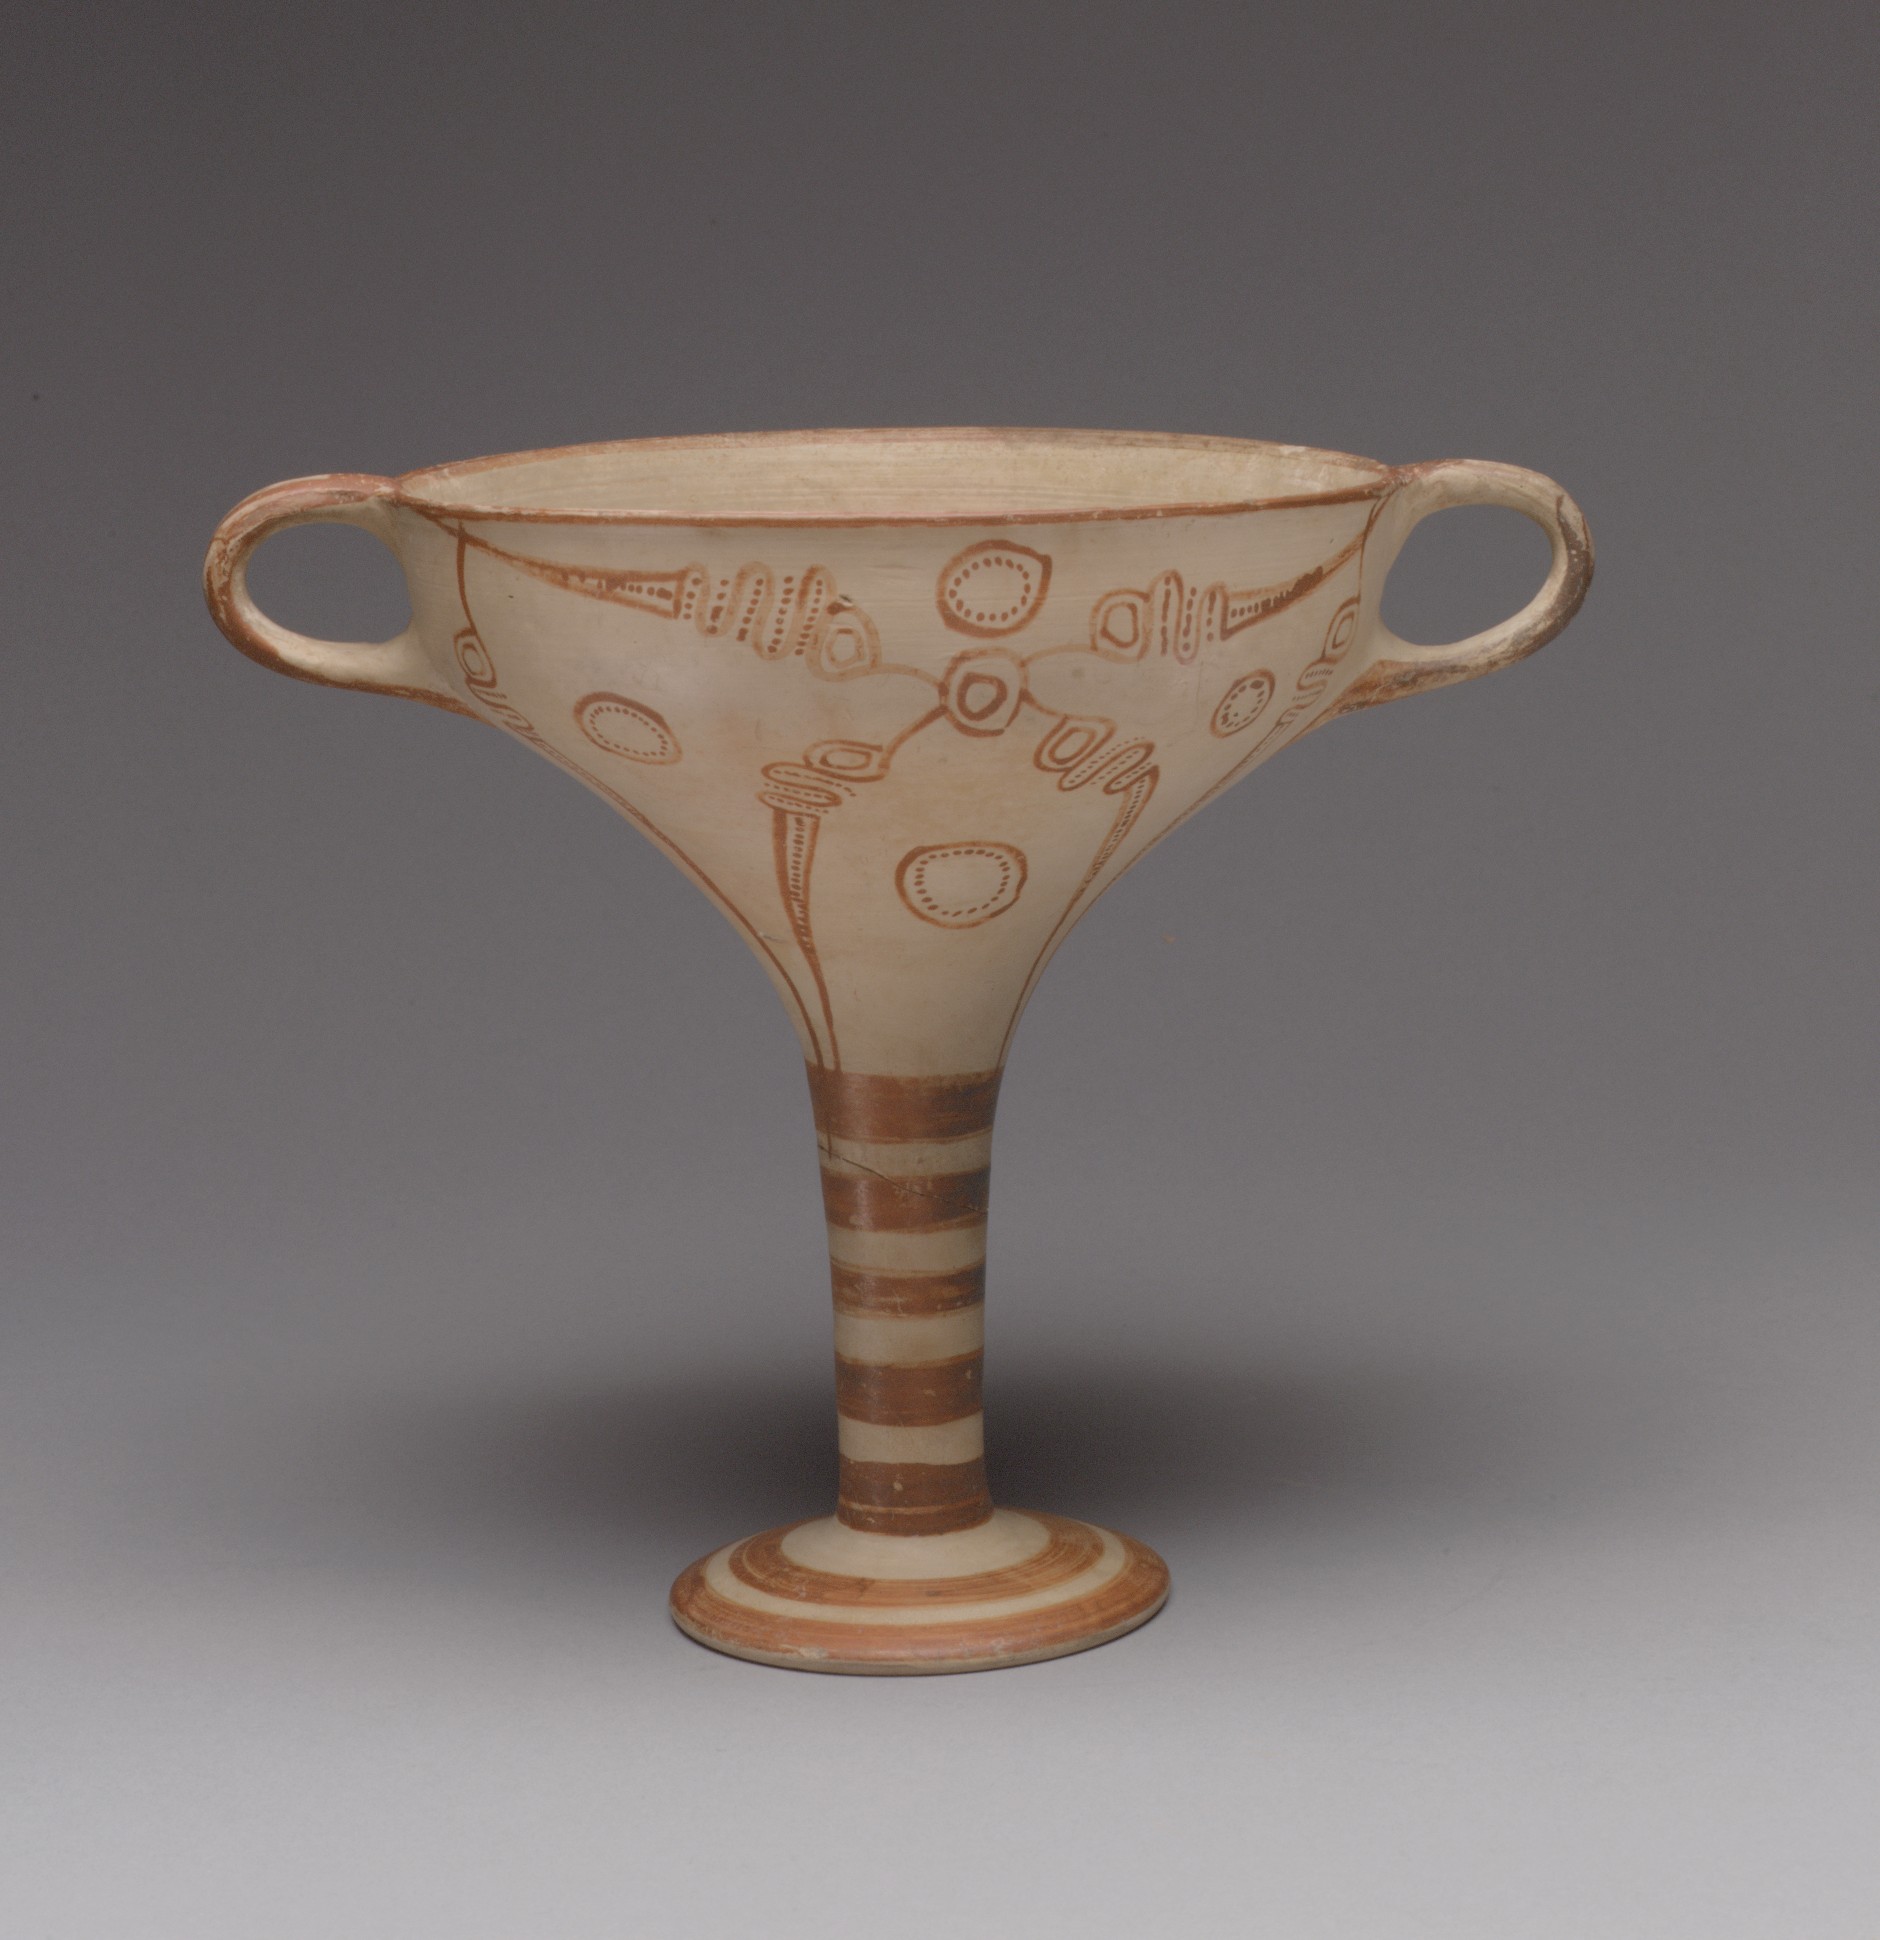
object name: cup, stemmed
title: Terracotta stemmed cup with murex decoration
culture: aegean, helladic or mycenaean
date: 1400-1300 BCE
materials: terracotta